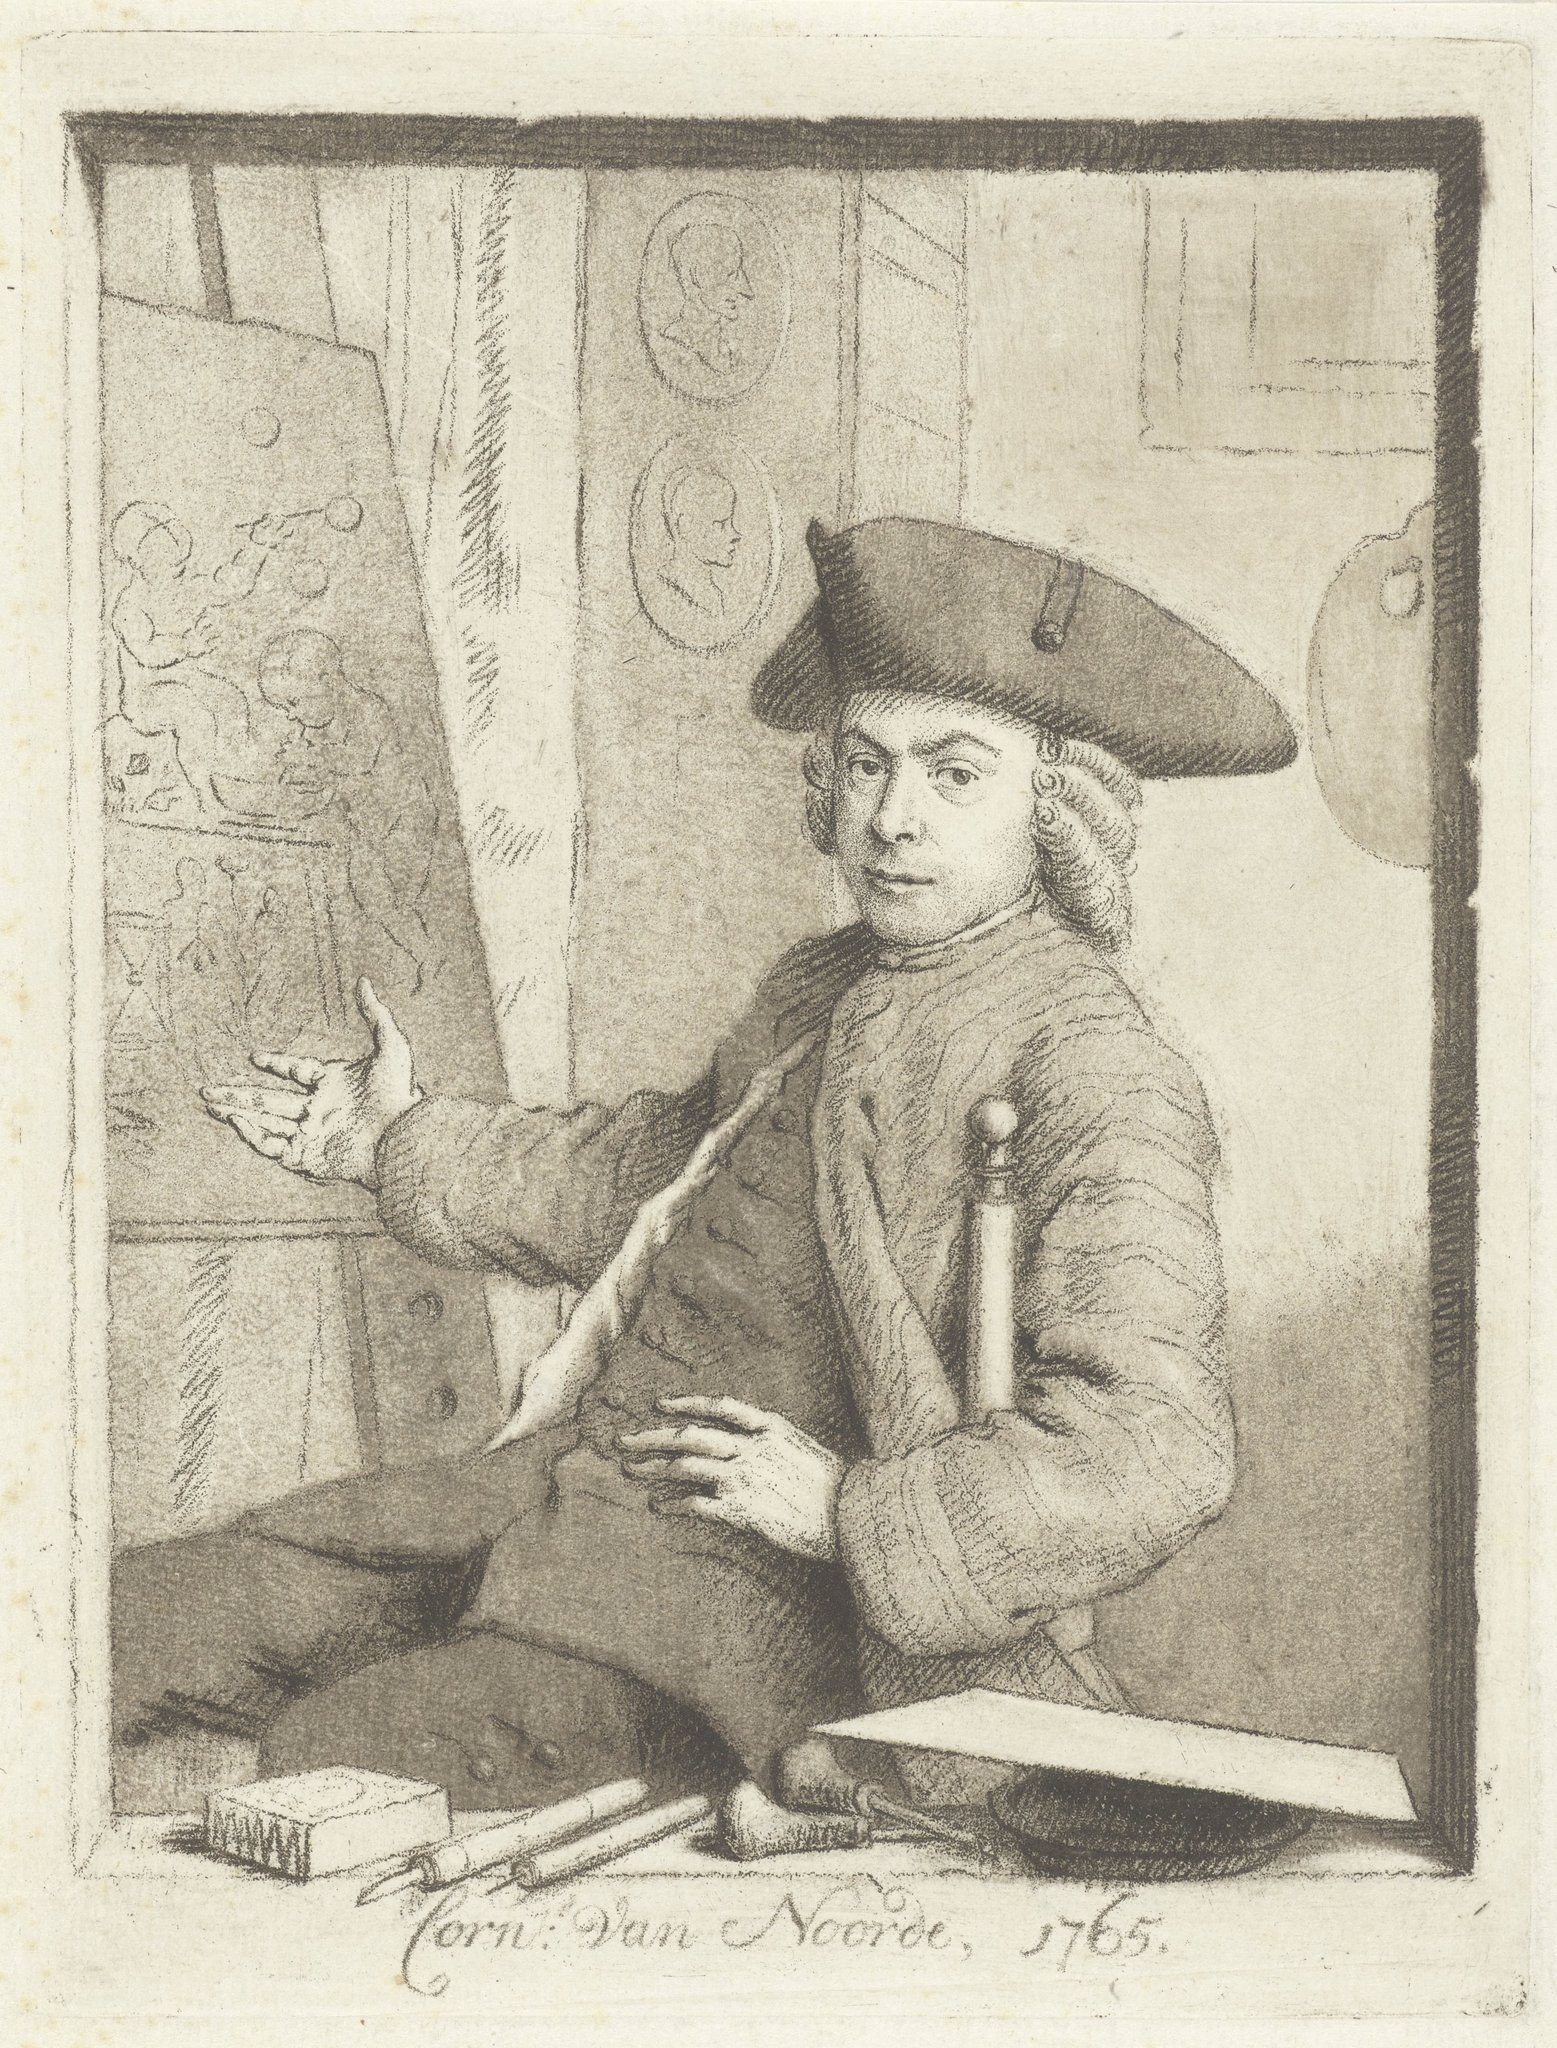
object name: print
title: Zelfportret van Cornelis van Noorde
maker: cornelis van noorde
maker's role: draughtsman, print maker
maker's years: 1731-1795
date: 1765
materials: paper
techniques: printmaking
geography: haarlem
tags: haarlem, draughtsman, cornelis van noorde, tools, implements of graphic artist, portrait, self-portrait of artist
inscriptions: collector's mark: Lugt 2760, inscription: ‘door Corn: van Noorde na 't Leeven geteekend en in 't koper gebragt, 1765.’, collector's mark: Lugt 2228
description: Zelfportret van Cornelis van Noorde, zittend naast zijn schildersezel, wijzend naar het schilderij dat erop staat. Op de voorgrond liggen de attributen van de graveur.